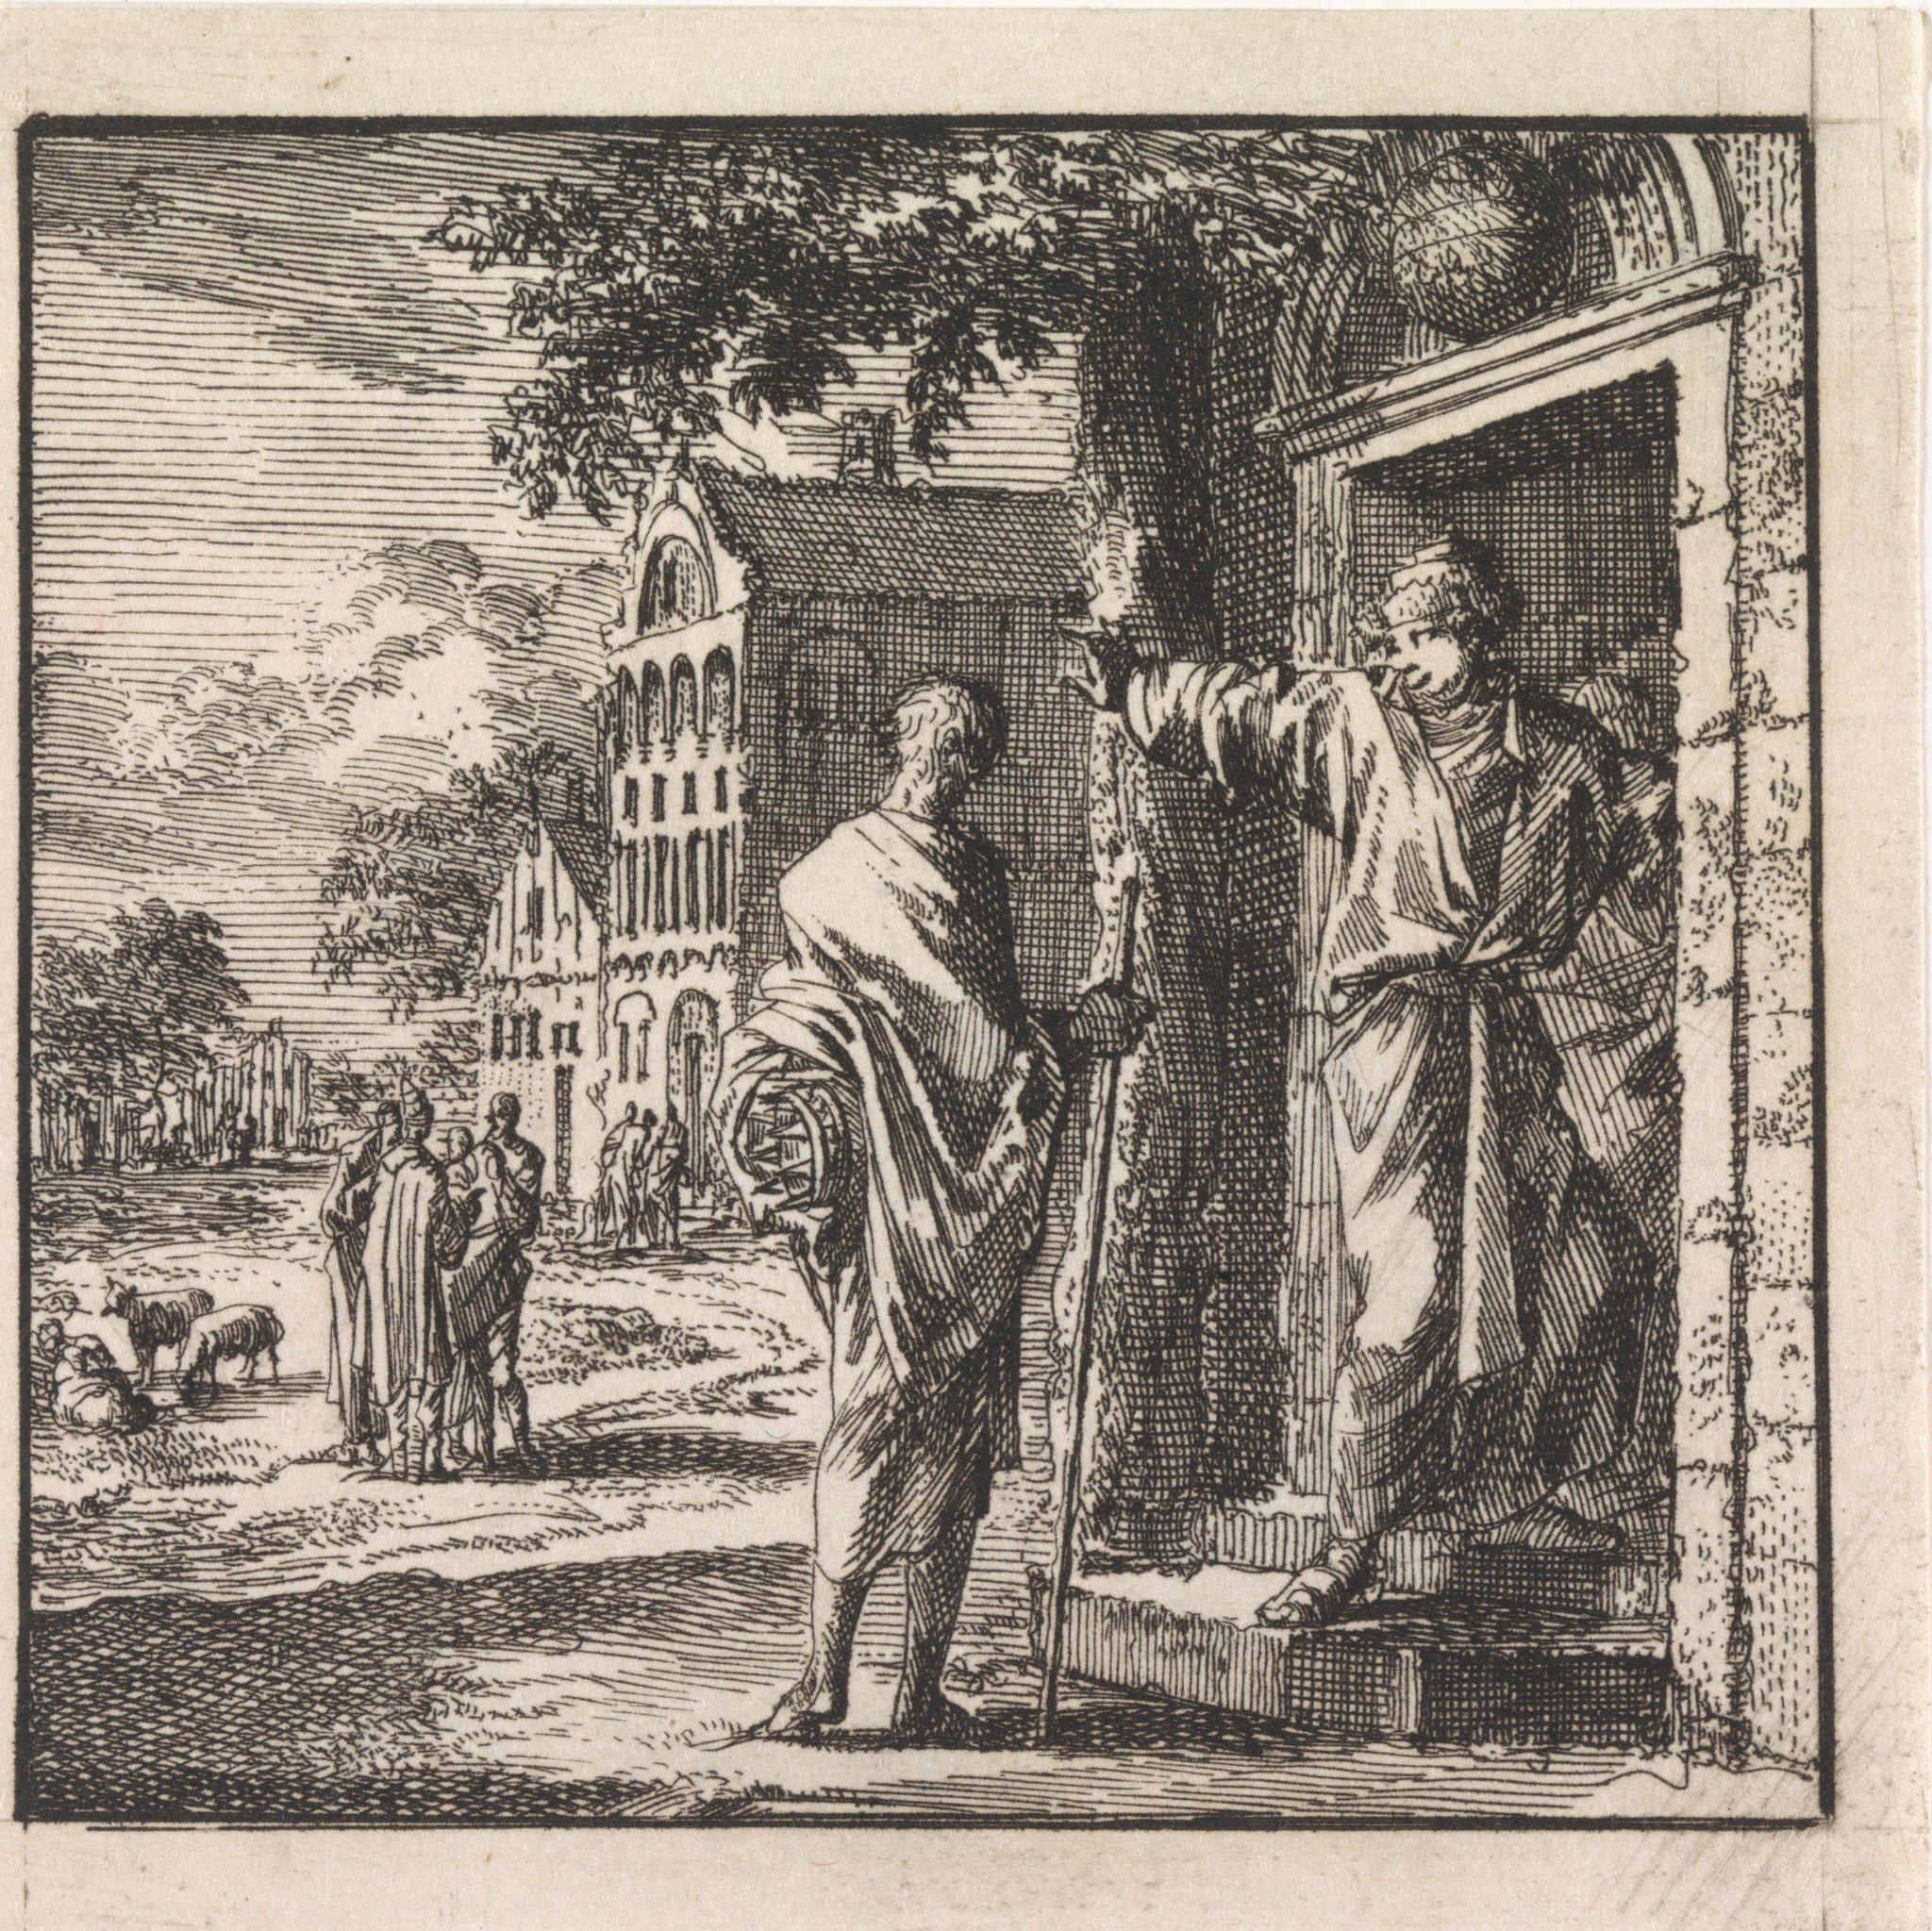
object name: print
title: De Schadelyke Afwyzing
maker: jan luyken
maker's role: draughtsman, print maker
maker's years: 1649-1712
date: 1710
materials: paper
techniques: etching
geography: amsterdam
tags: earth, world as celestial body, refusal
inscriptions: collector's mark: Lugt 2228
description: Proefdruk voor illustratie uit: Luyken, Jan. De onwaardige wereld, vertoond in vyftig zinnebeelden, met godlyke spreuken en stichtelyke verzen. Amsterdam: Pieter Arentsz. II (wed.) en Cornelis van der Sys, 1710, p. 168.